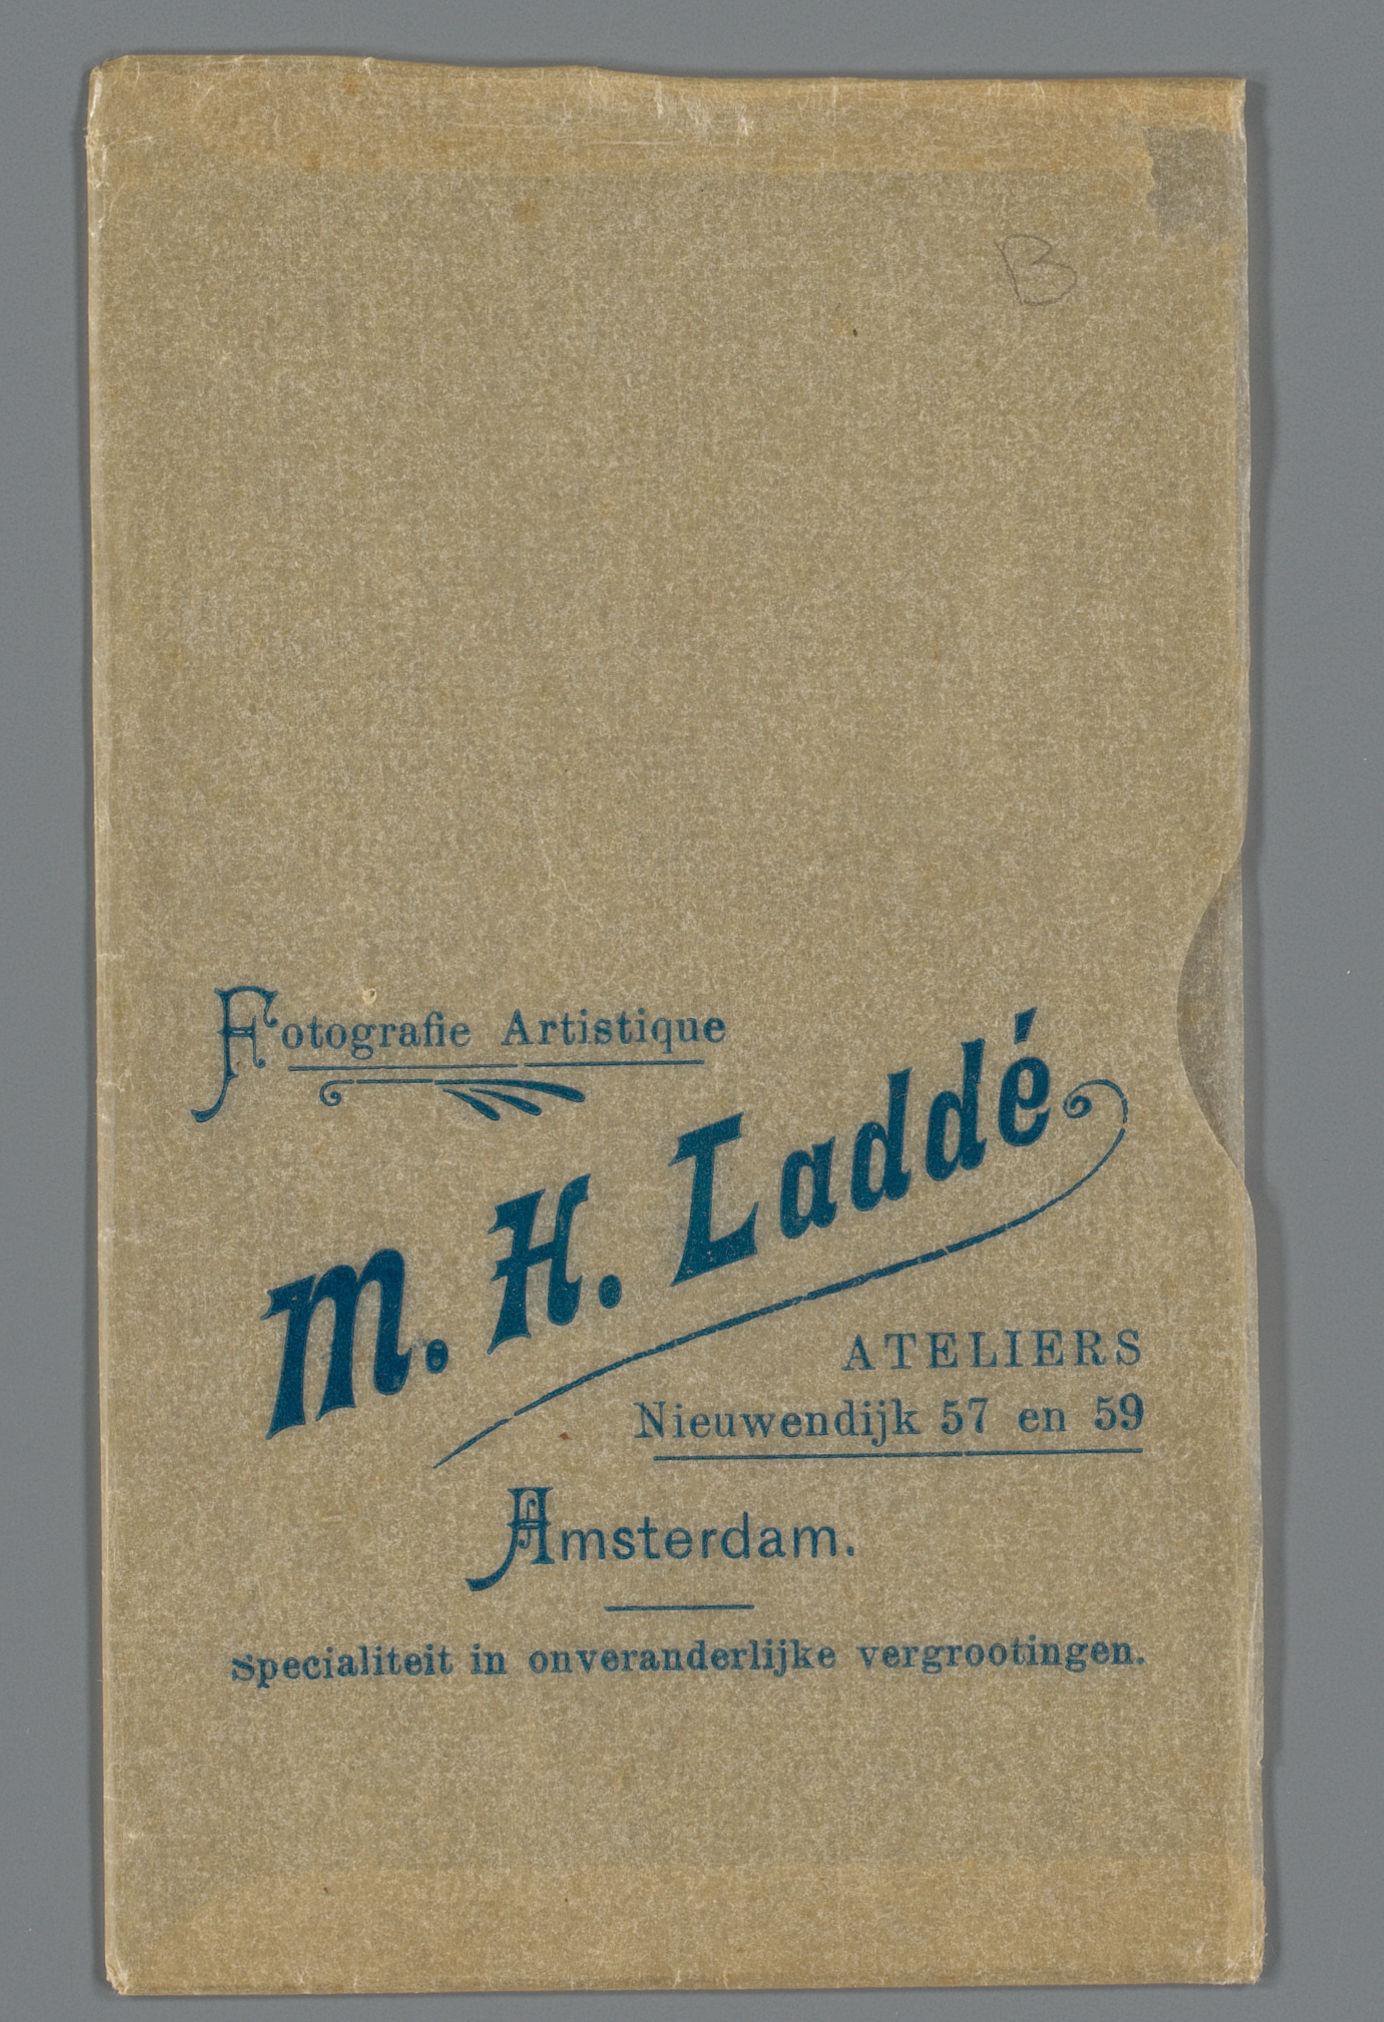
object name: covering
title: Hoes voor een carte-de-visite gemaakt door M.H. Laddé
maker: machiel hendricus laddé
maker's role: fotograaf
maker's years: 1866-1932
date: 1911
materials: paper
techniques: letterpress printing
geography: amsterdam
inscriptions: inscription: ‘Fotografie Artistique/ M.H. Laddé/ Ateliers/ Nieuwendijk 57 en 59/ Amsterdam./ Specialiteit in onveranderlijke vergrootingen.’